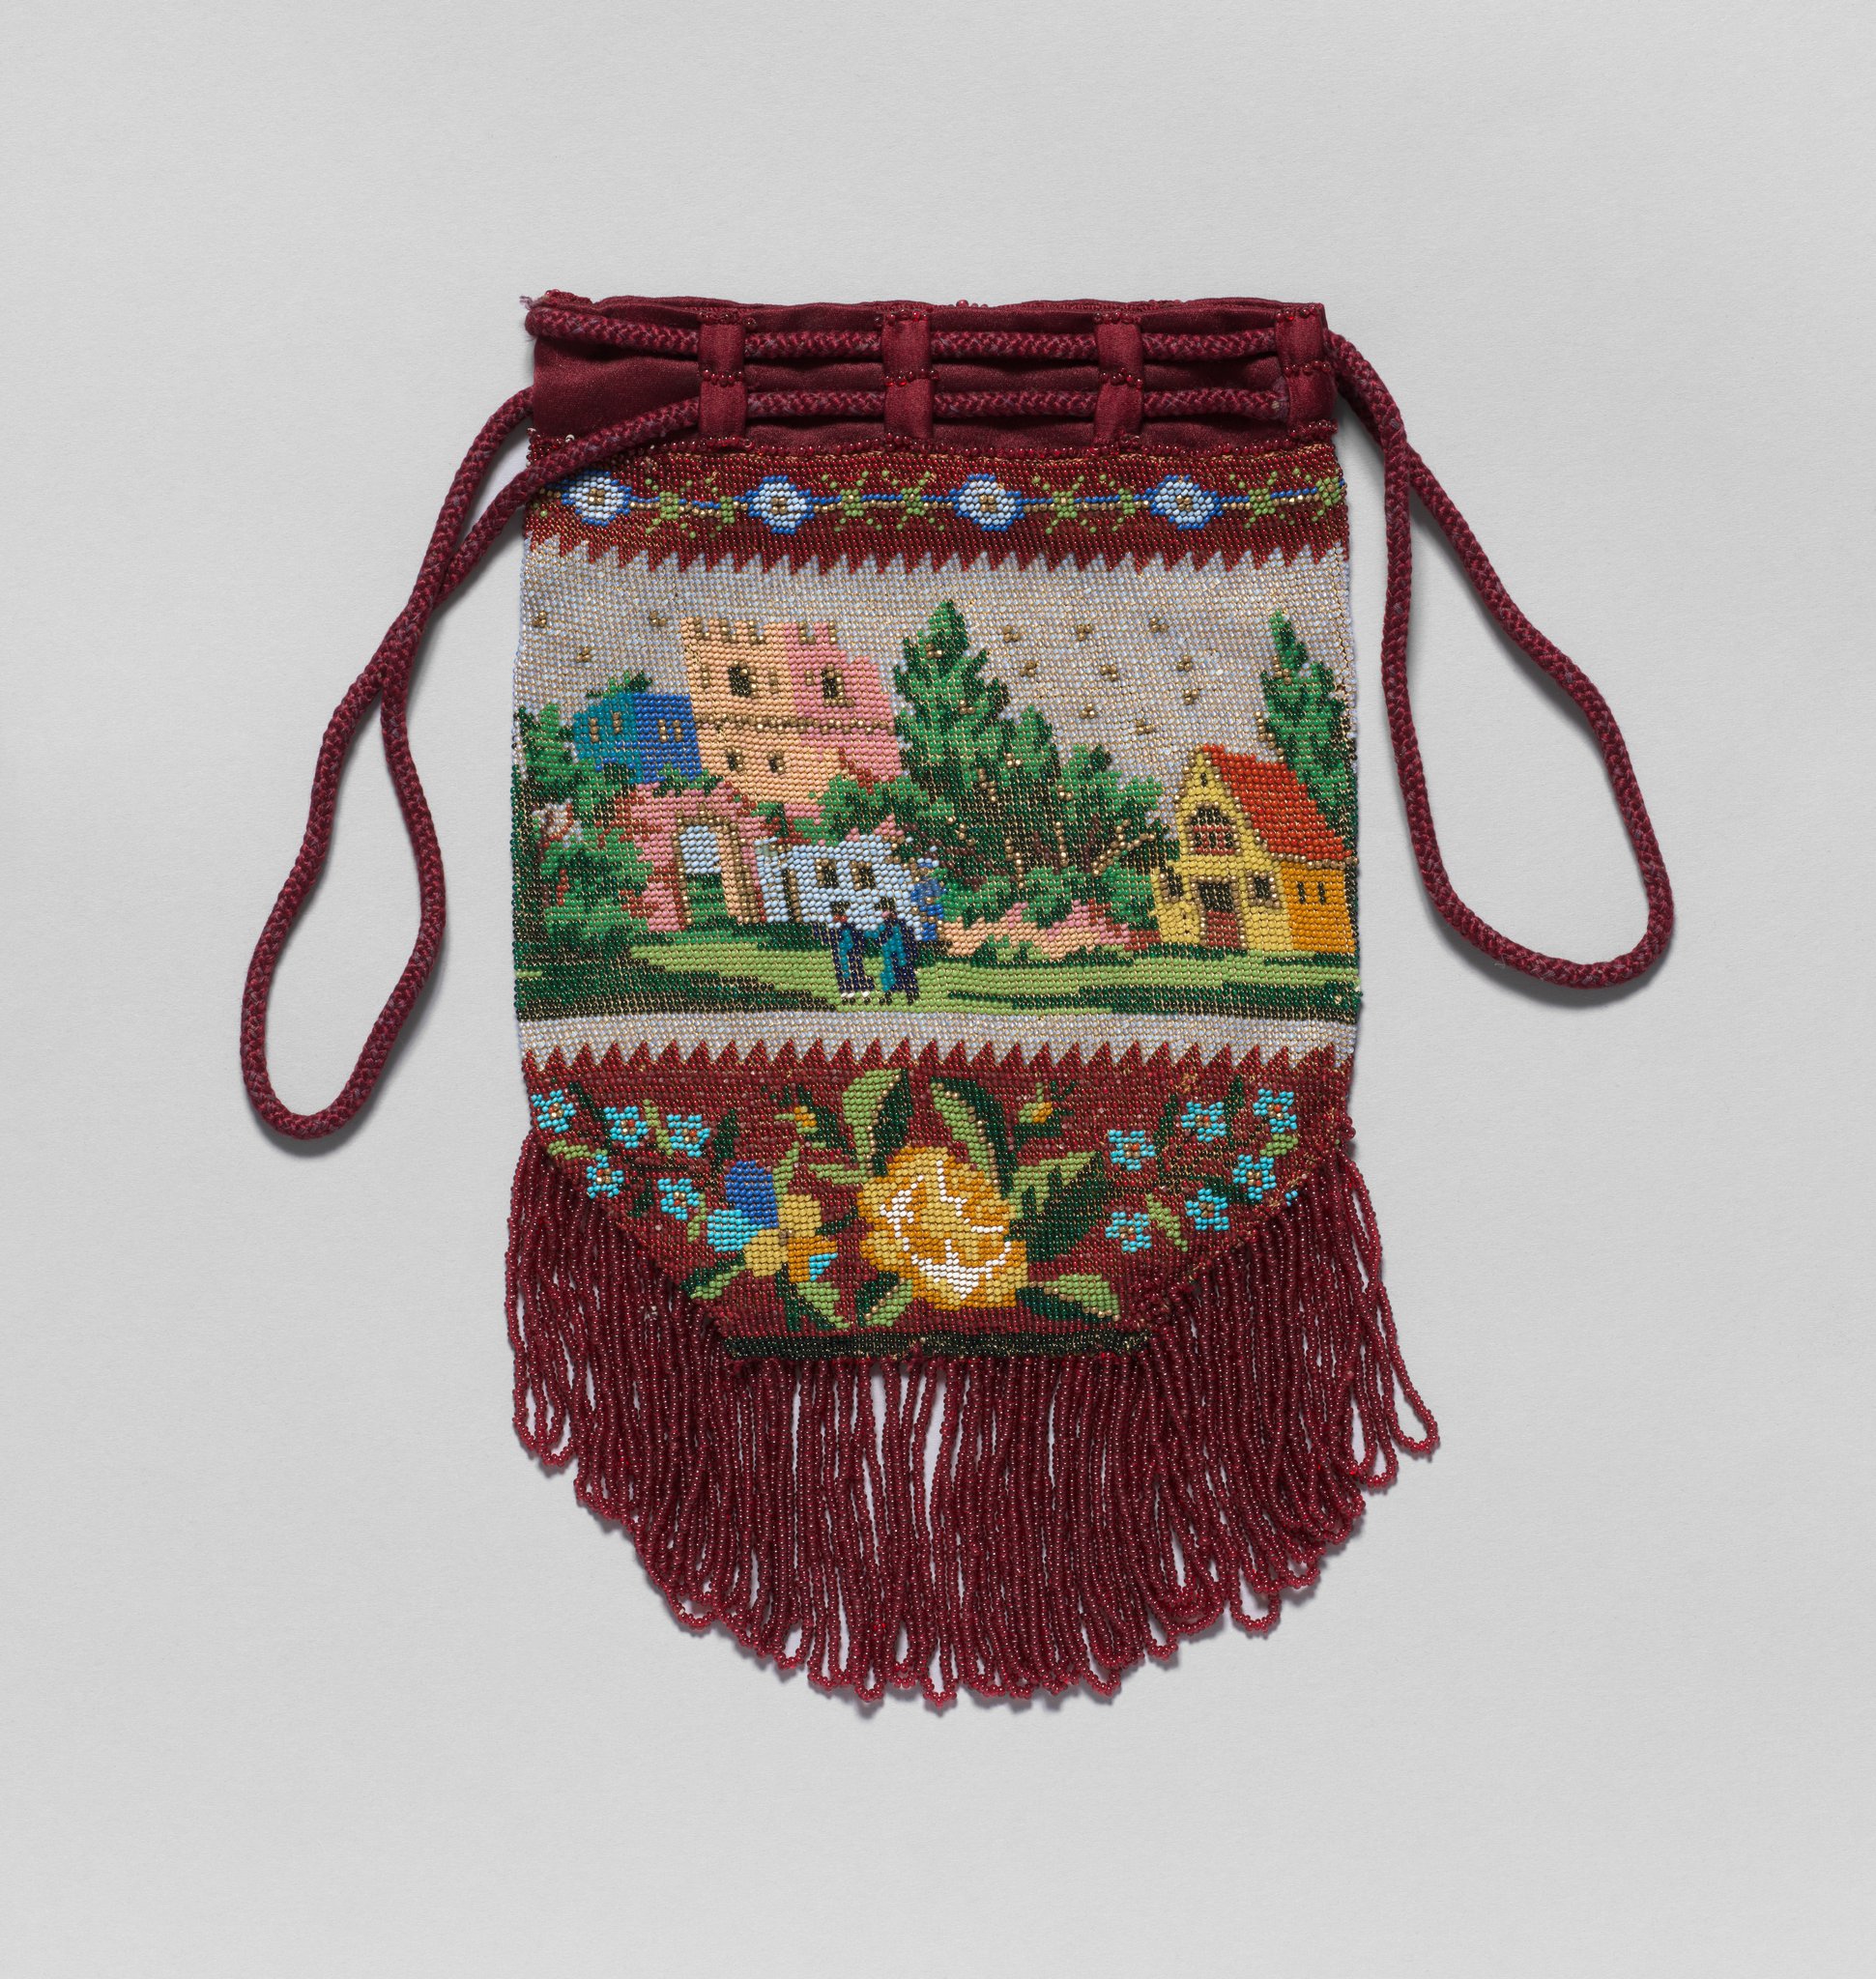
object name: bag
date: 1801-1833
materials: glass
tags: castles